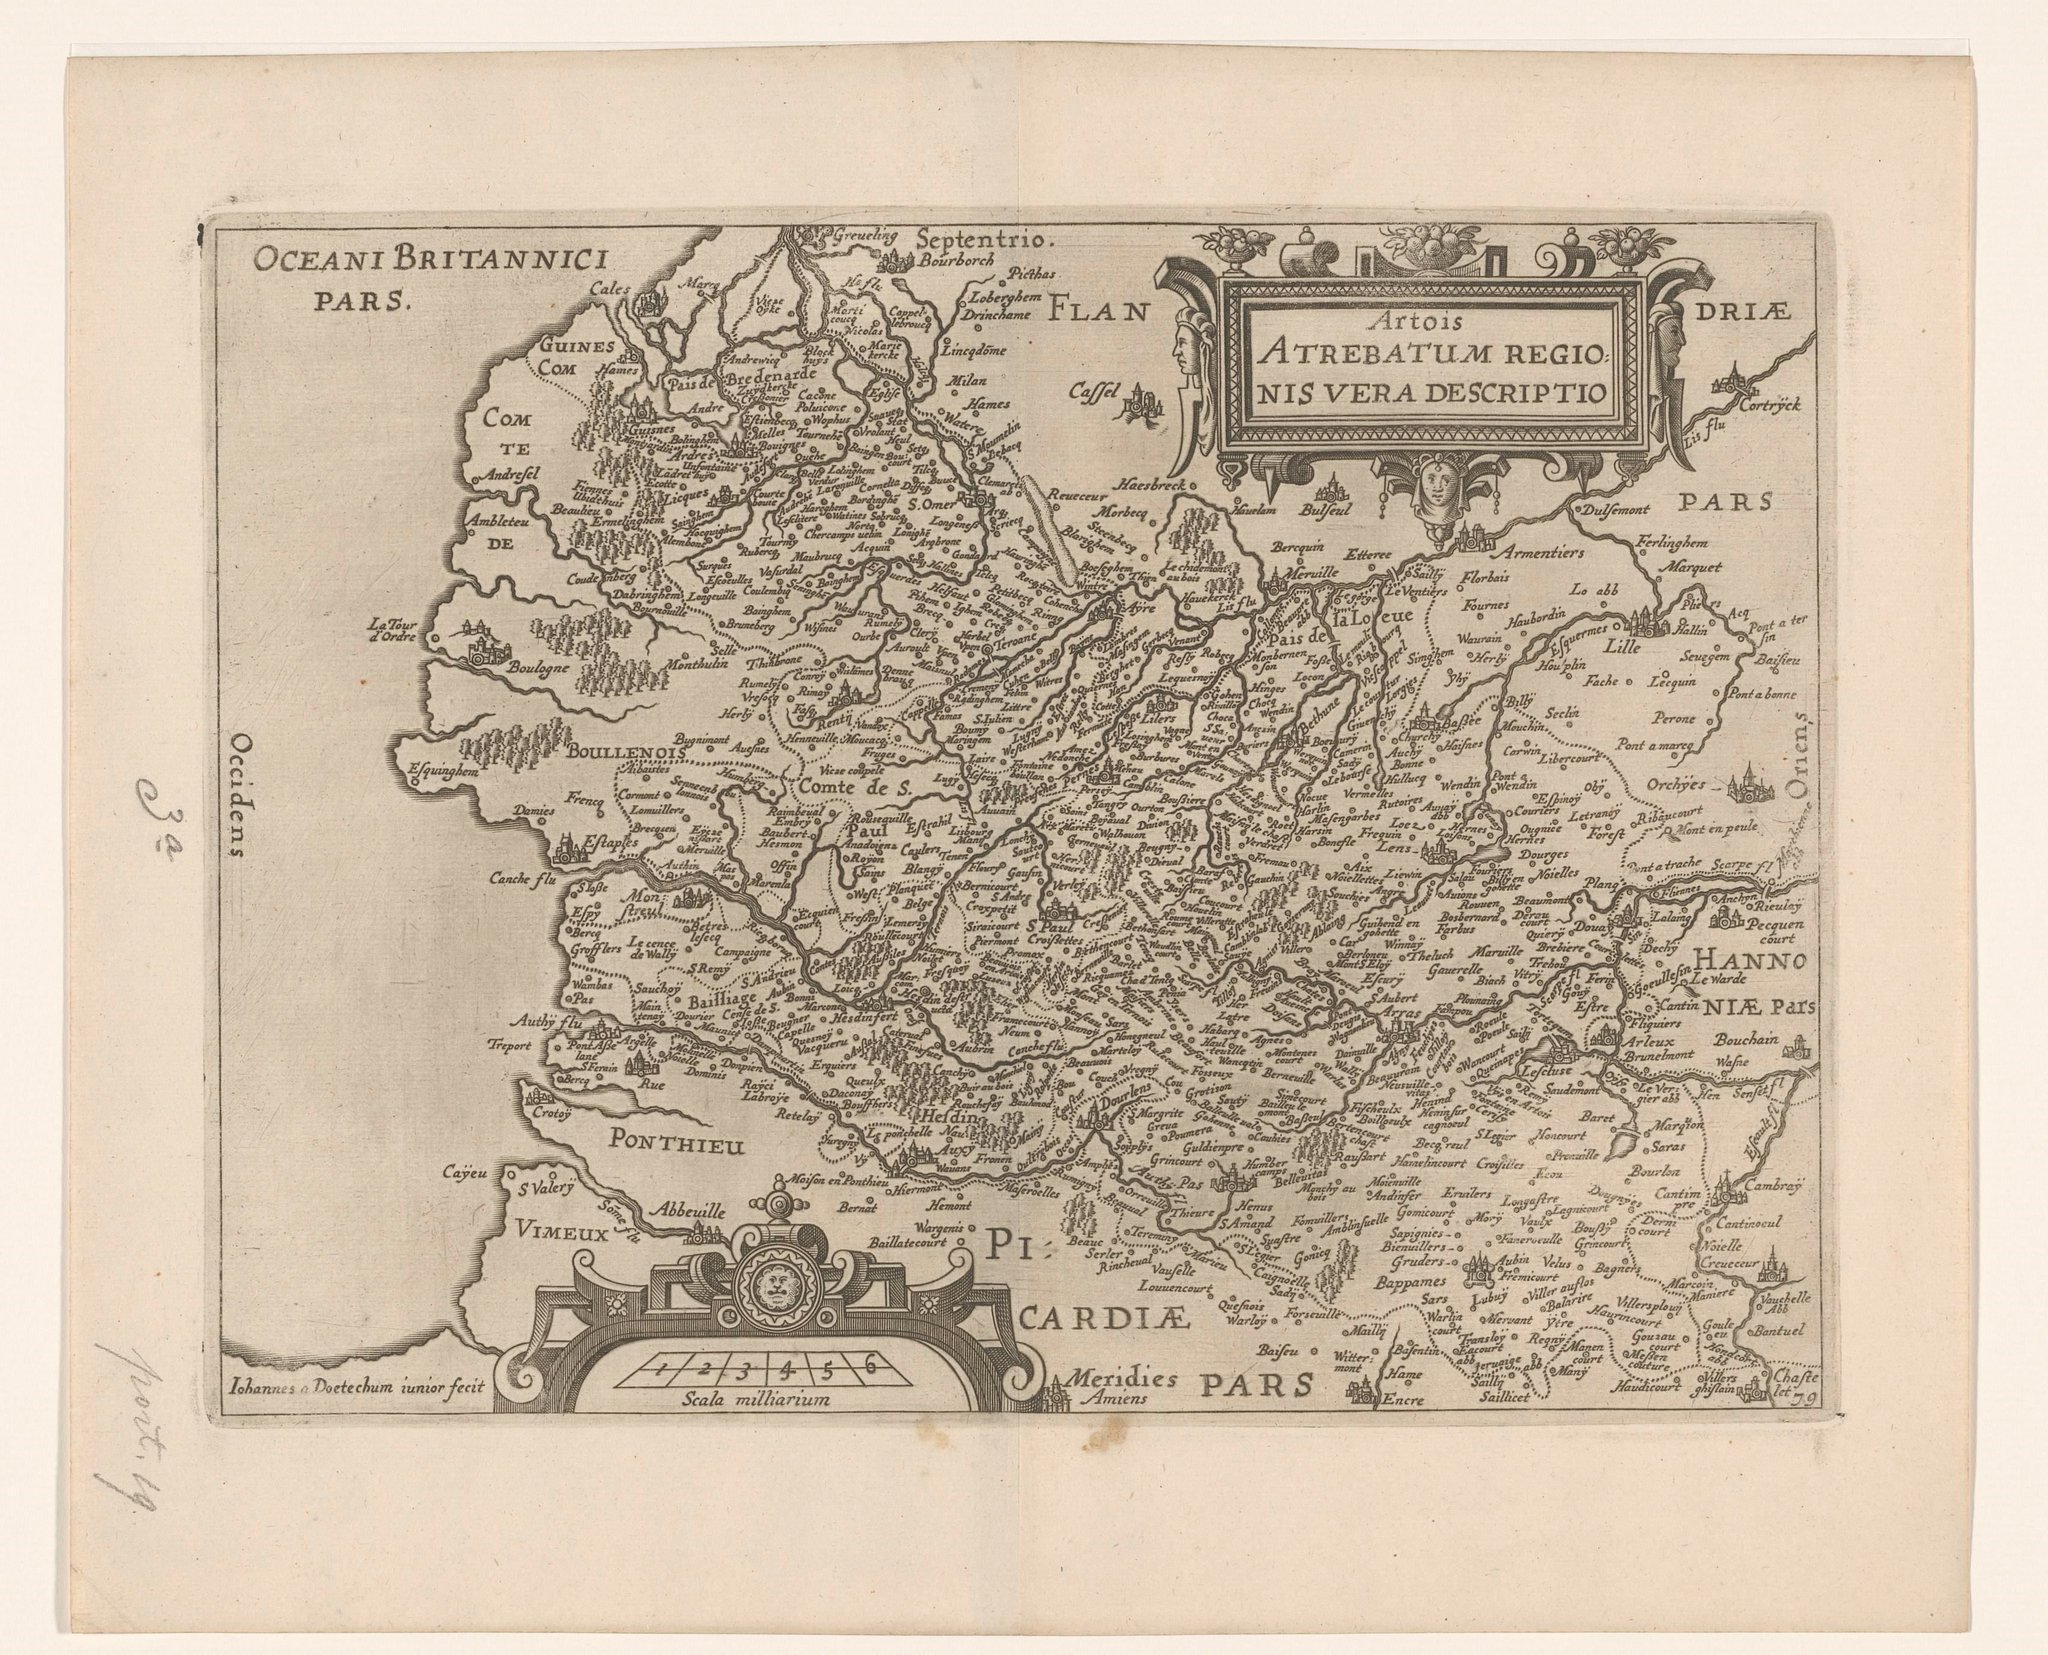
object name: map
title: Artois atrebatum regionis vera descriptio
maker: joannes van doetechum (ii)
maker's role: print maker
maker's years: 1558-1630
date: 1612-1648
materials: paper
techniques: engraving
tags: maps of separate countries or regions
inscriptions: collector's mark: Lugt 2228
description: Deze staat van prent voor het eerst ook gebruikt in: Guicciardini, Lodovico. Beschryvinghe van alle de Neder-landen, anderssins ghenoemt Neder-Duytslandt (…). Amsterdam: Willem Janszoon Blaeu, 1612. Hierna is deze prent tot 1648 nog gebruikt in latere uitgaven van deze publicatie, uitgegeven door Blaeu en daarna door Janssonius. Uit welke uitgave het huidige exemplaar precies komt is niet na te gaan.